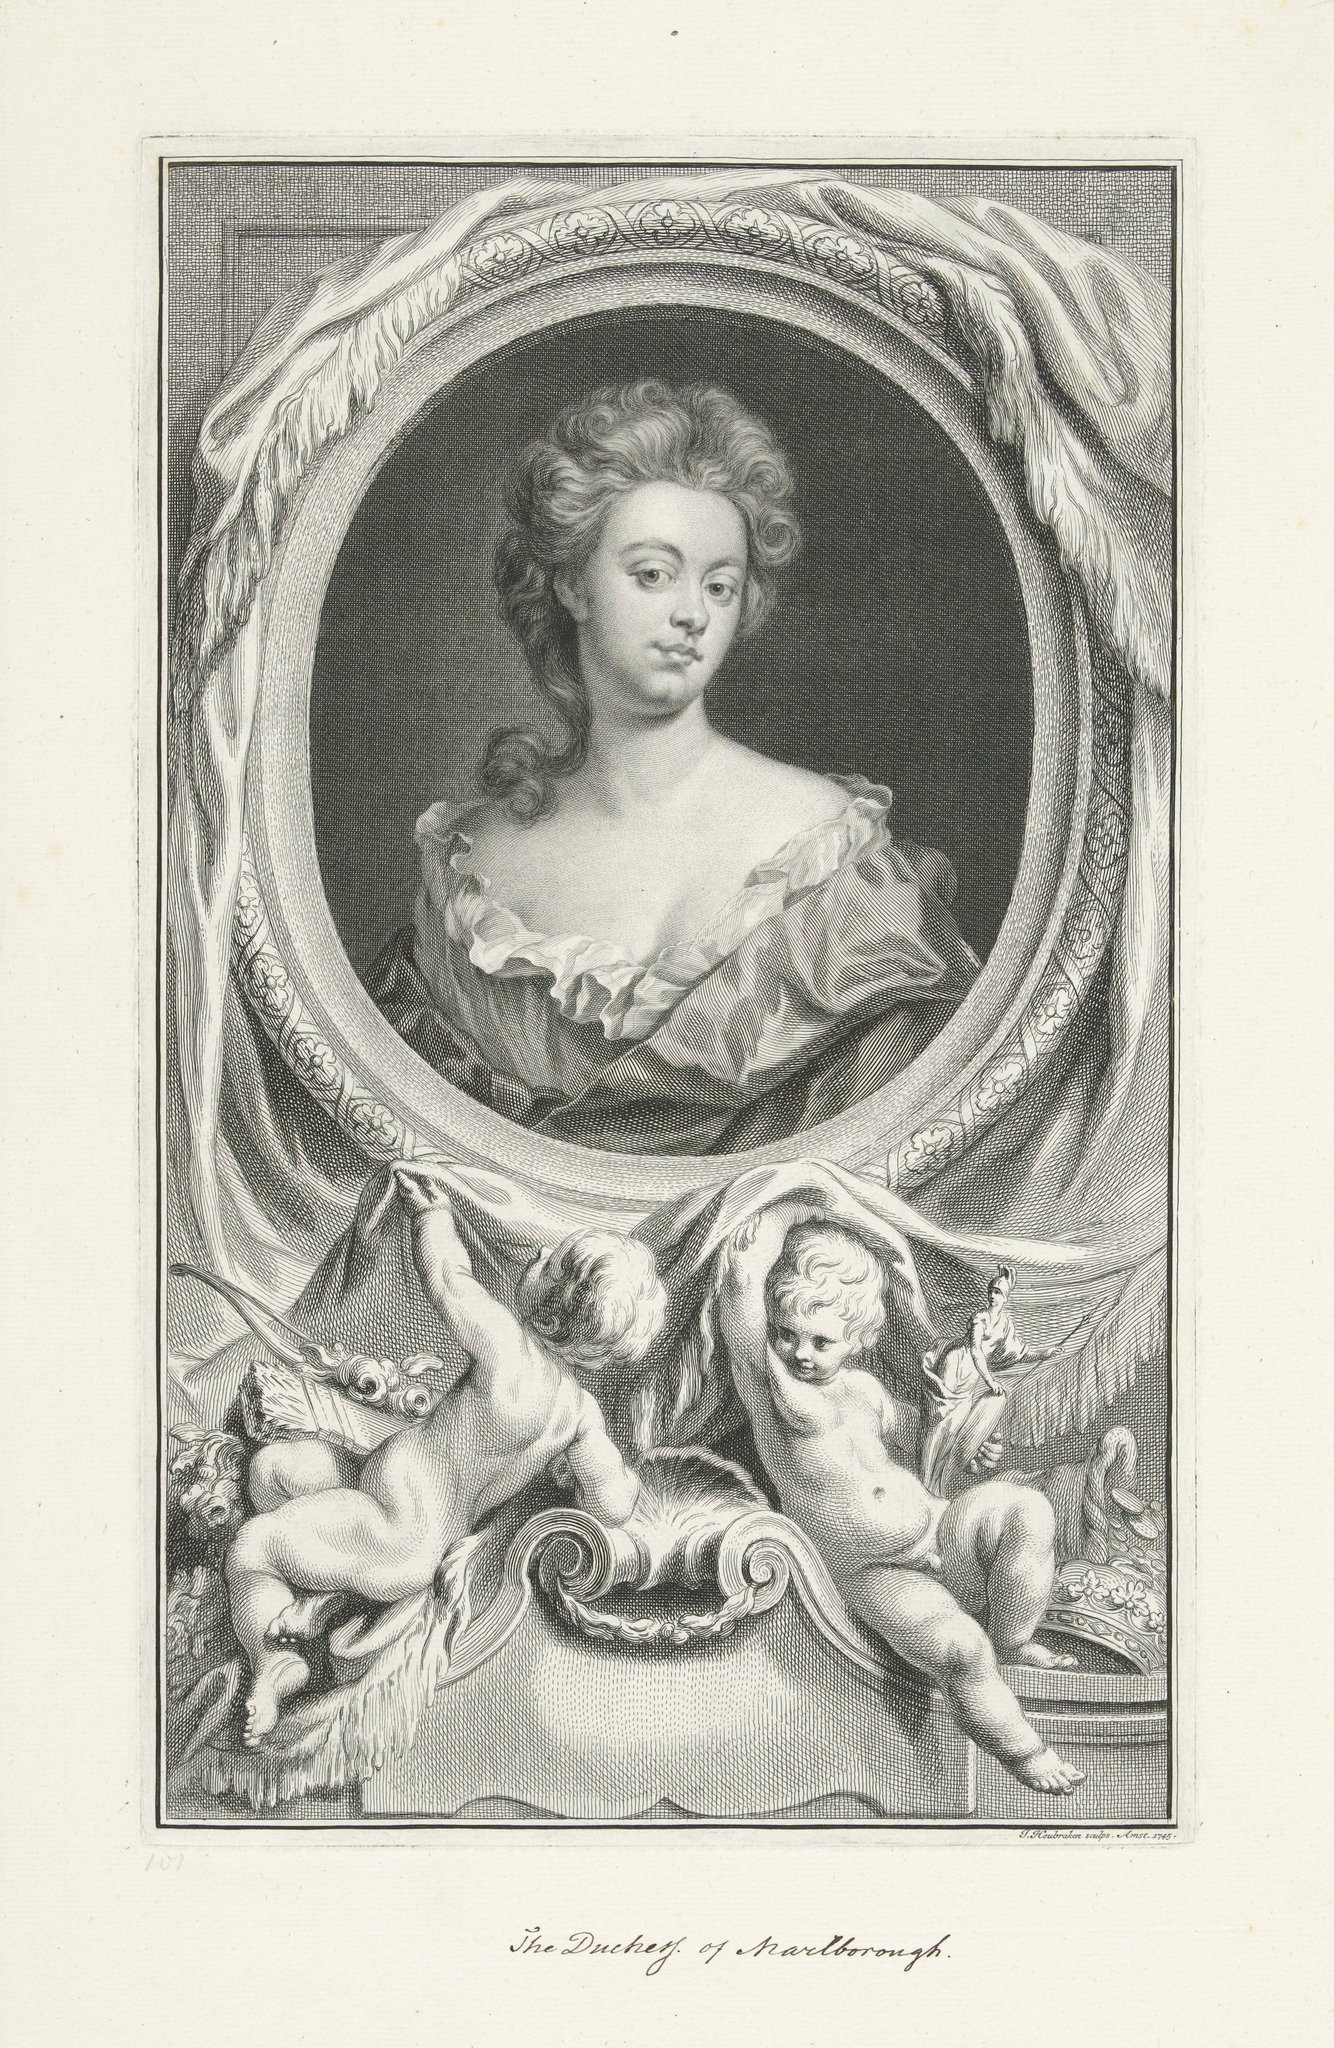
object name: print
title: Portret van Sarah Churchill, hertogin van Marlborough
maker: jacob houbraken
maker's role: draughtsman, print maker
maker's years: 1698-1780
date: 1745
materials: paper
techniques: engraving, etching, pen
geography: amsterdam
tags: sarah churchill (hertogin van marlborough)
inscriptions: collector's mark: Lugt 240, name: ‘The Duchess of Marlborough’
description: Prent ook gebruikt in: Nicholas Tindal. The History of England, by Mr. Rapin de Thoyras. Continued from the Revolution to the Accession of King George II (...). 13 dln. Londen: John en Paul Knapton, 1744-1747.